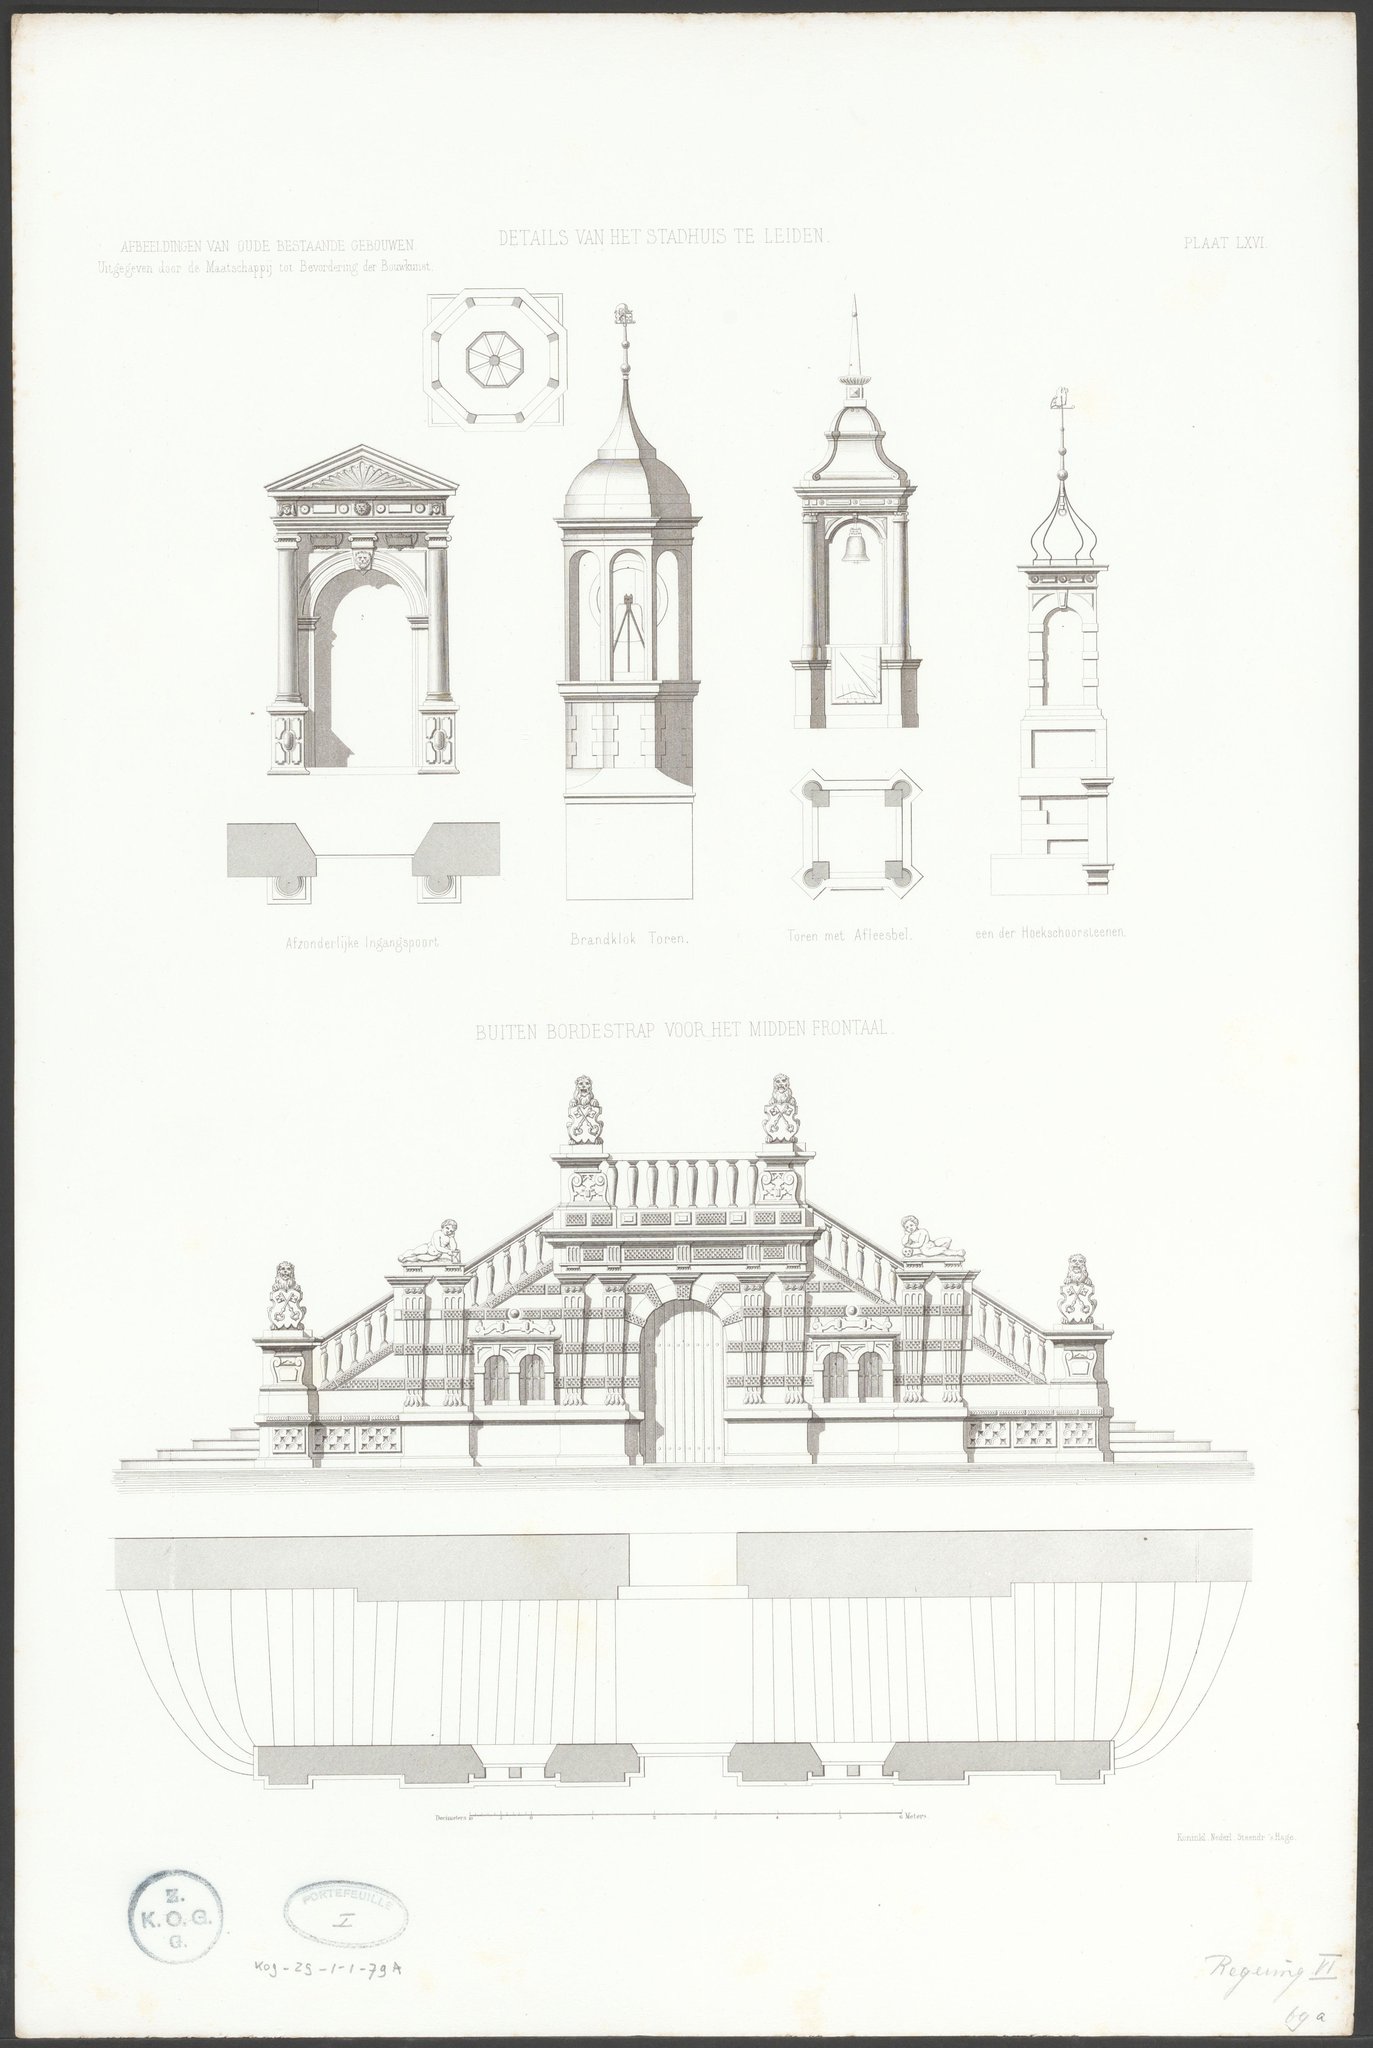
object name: print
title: Afbeeldingen van oude bestaande gebouwen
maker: ruurt de vries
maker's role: print maker, printer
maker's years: 1813-1874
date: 1854-1907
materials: paper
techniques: lithograph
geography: the hague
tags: architectural detail, townhall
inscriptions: collector's mark, collector's mark: Lugt 1641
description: Details van het stadhuis van Leiden. Onderaan een schaalstok. Architectuurvoorstelling. Plaat LXVI. Onderwerpsrubrieken binnen de Atlas Zeden en Gewoonten: Regeering, Stadhuizen (H-M).